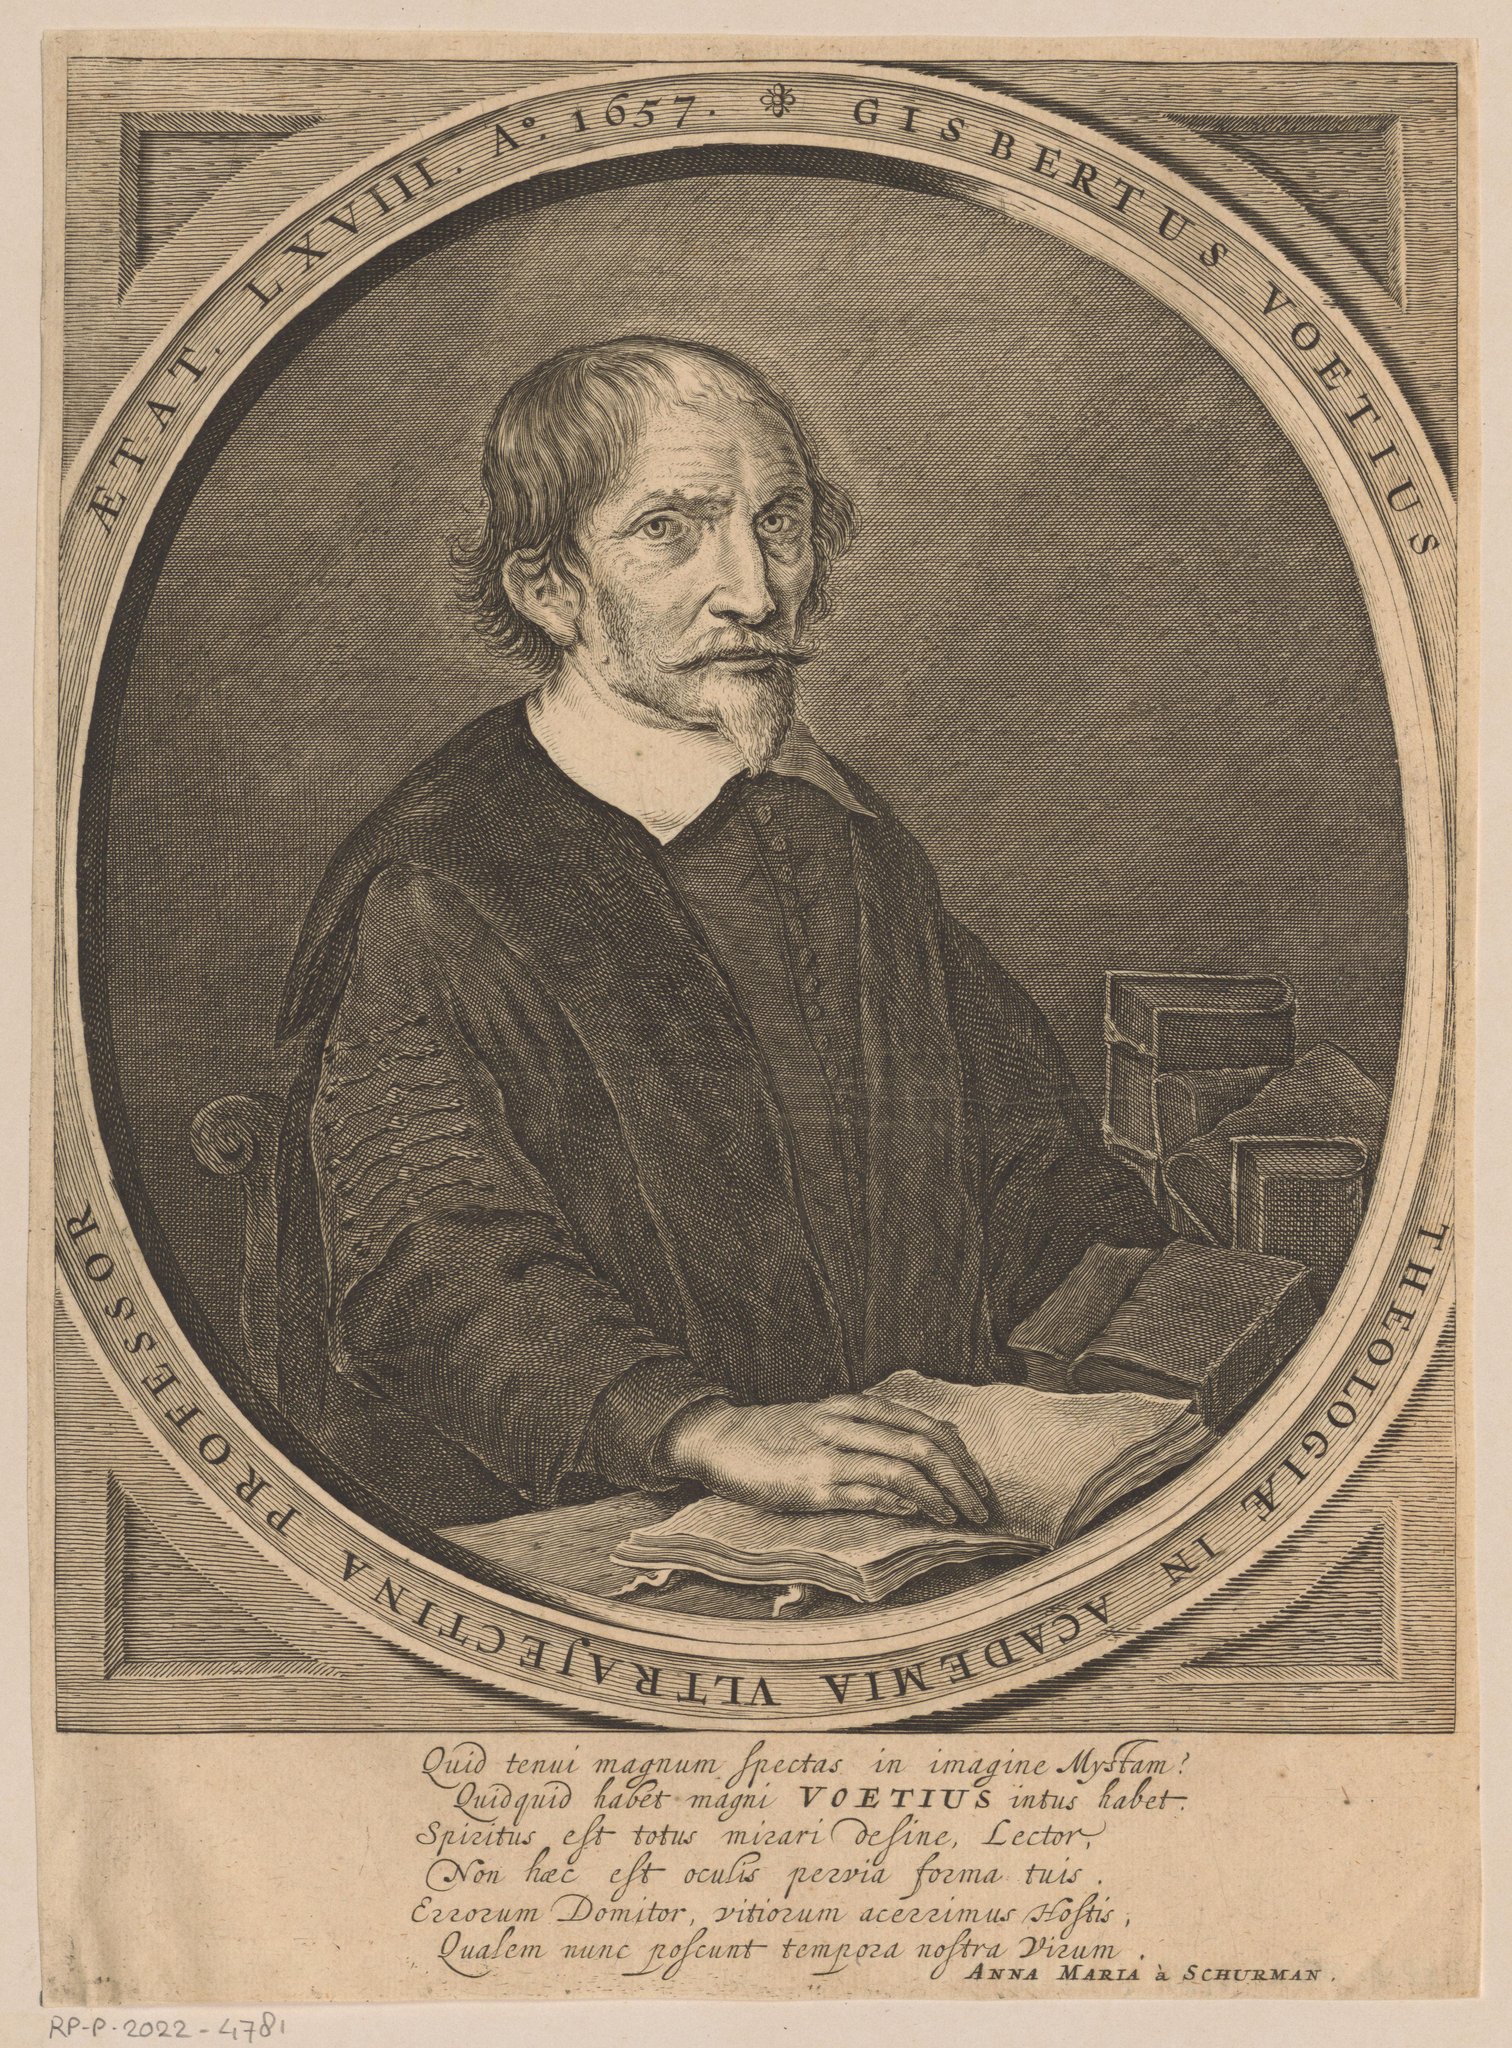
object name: print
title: Portret van Gijsbert Voet op 68-jarige leeftijd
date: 1657-1665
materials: paper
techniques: engraving, etching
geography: amsterdam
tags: theologian, scholar, philosopher, historical persons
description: Met zesregelig onderschrift in het Latijn.